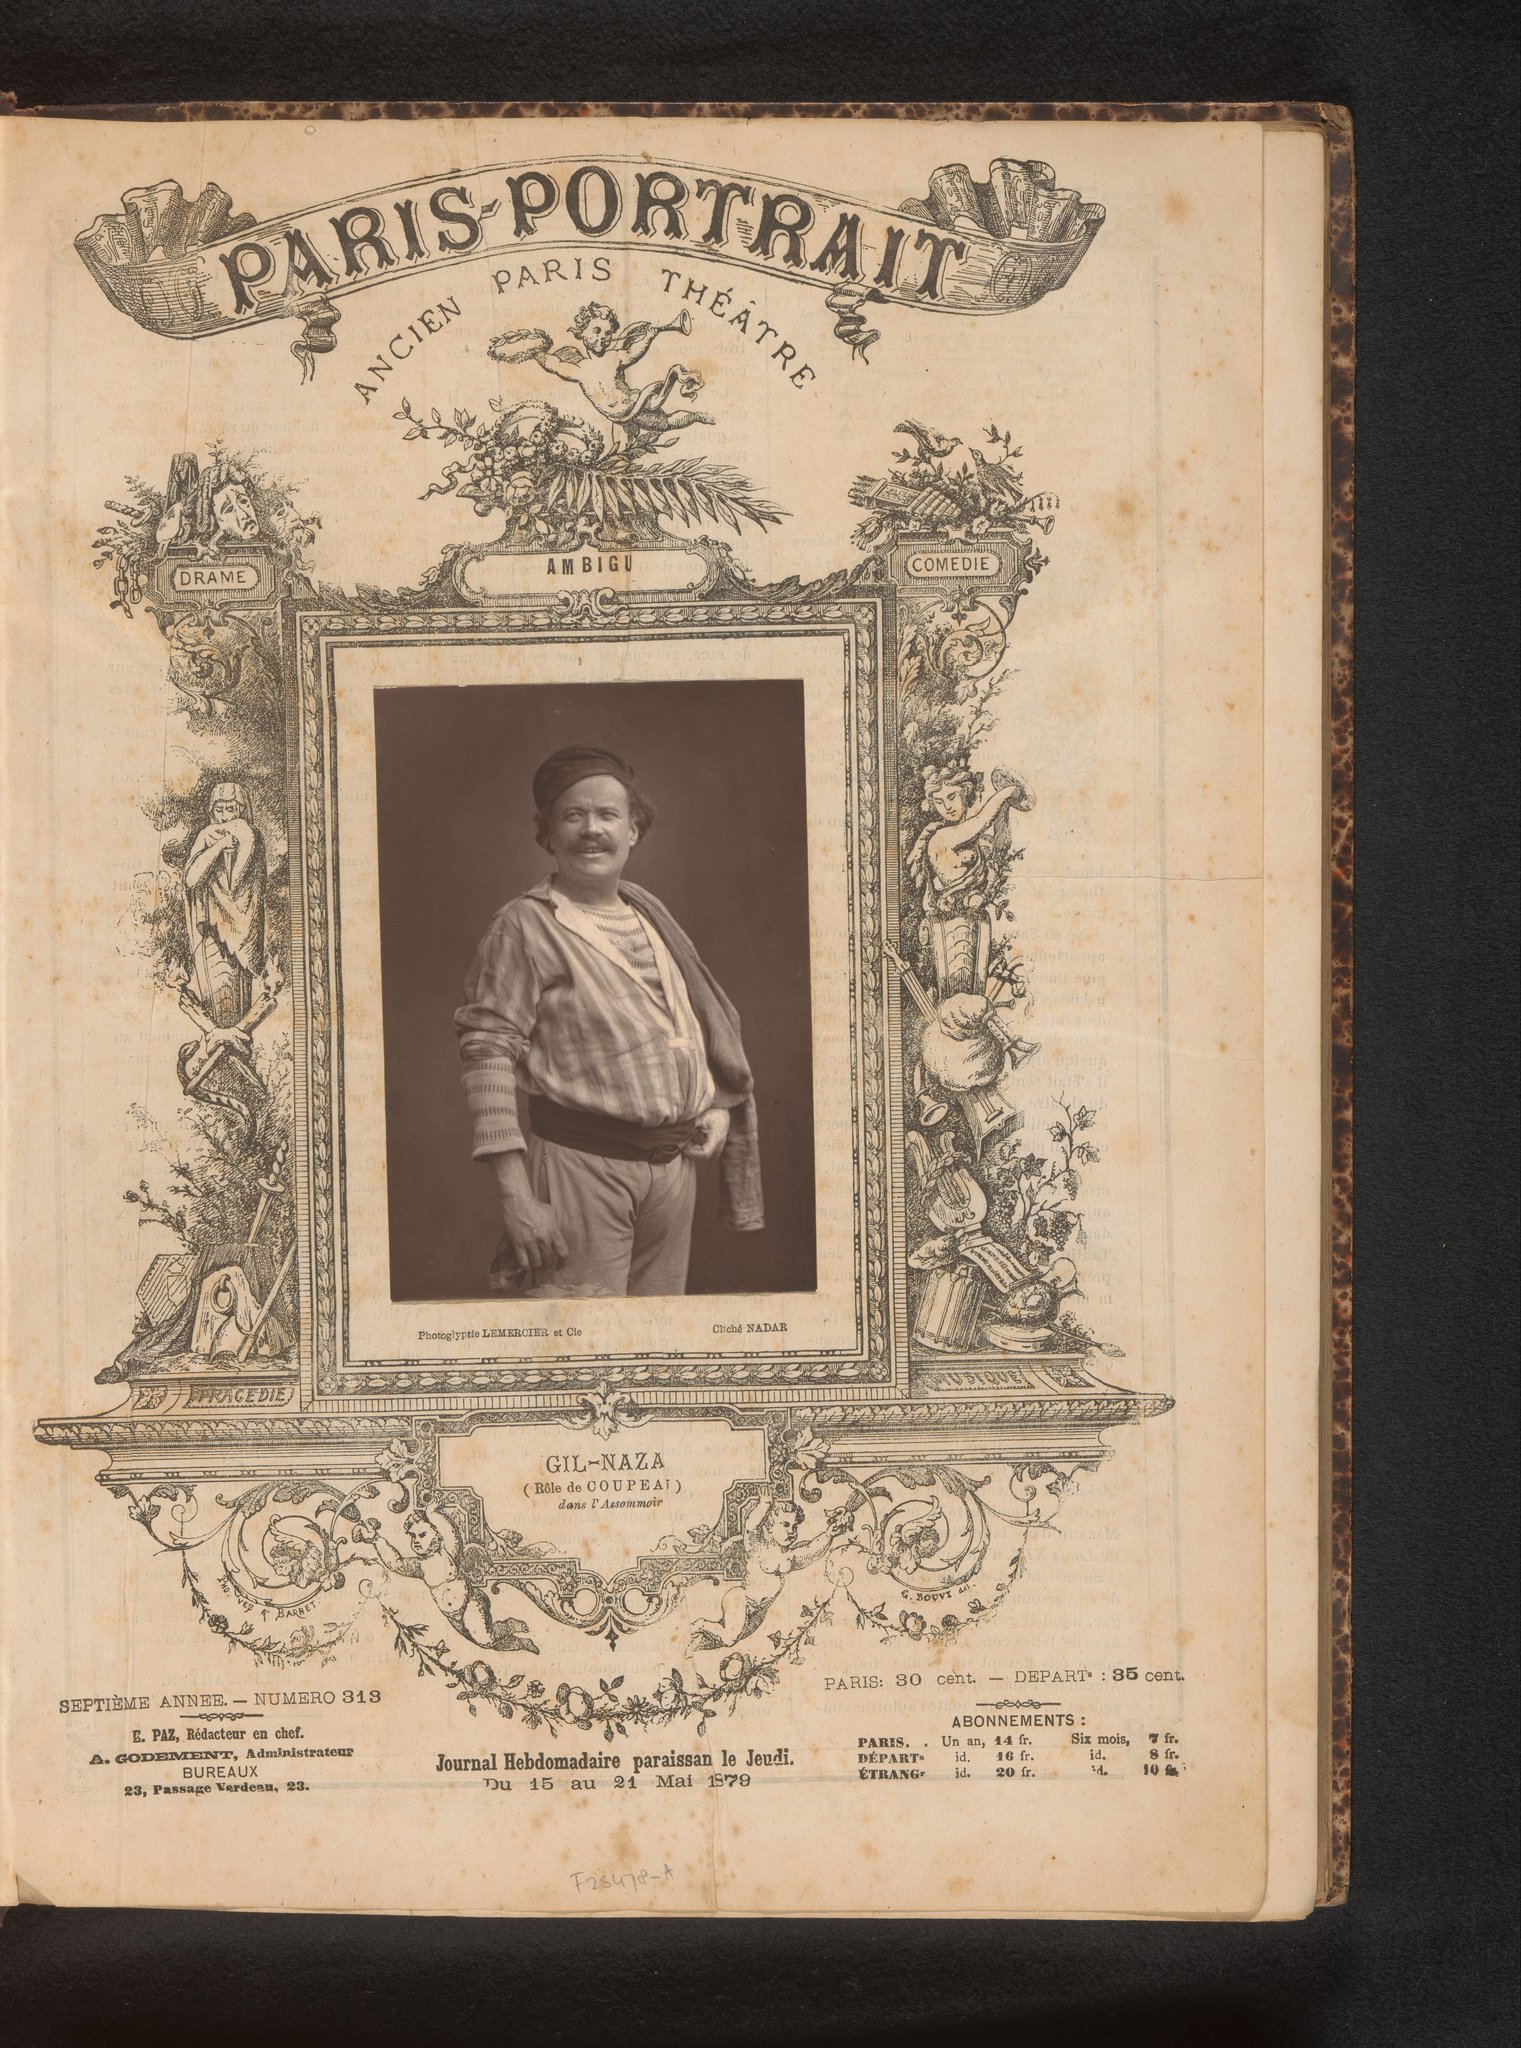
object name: magazine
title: Paris-Portrait : ancien Paris-Theatre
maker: eugène paz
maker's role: journalist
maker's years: 1835-1901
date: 1878-1880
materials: cardboard, linen, paper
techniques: printing, woodburytype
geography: paris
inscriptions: collector's mark: ‘Librairie du Spectacle/ Garnier Arnoul/ 39, Rue de Seine, PARIS’